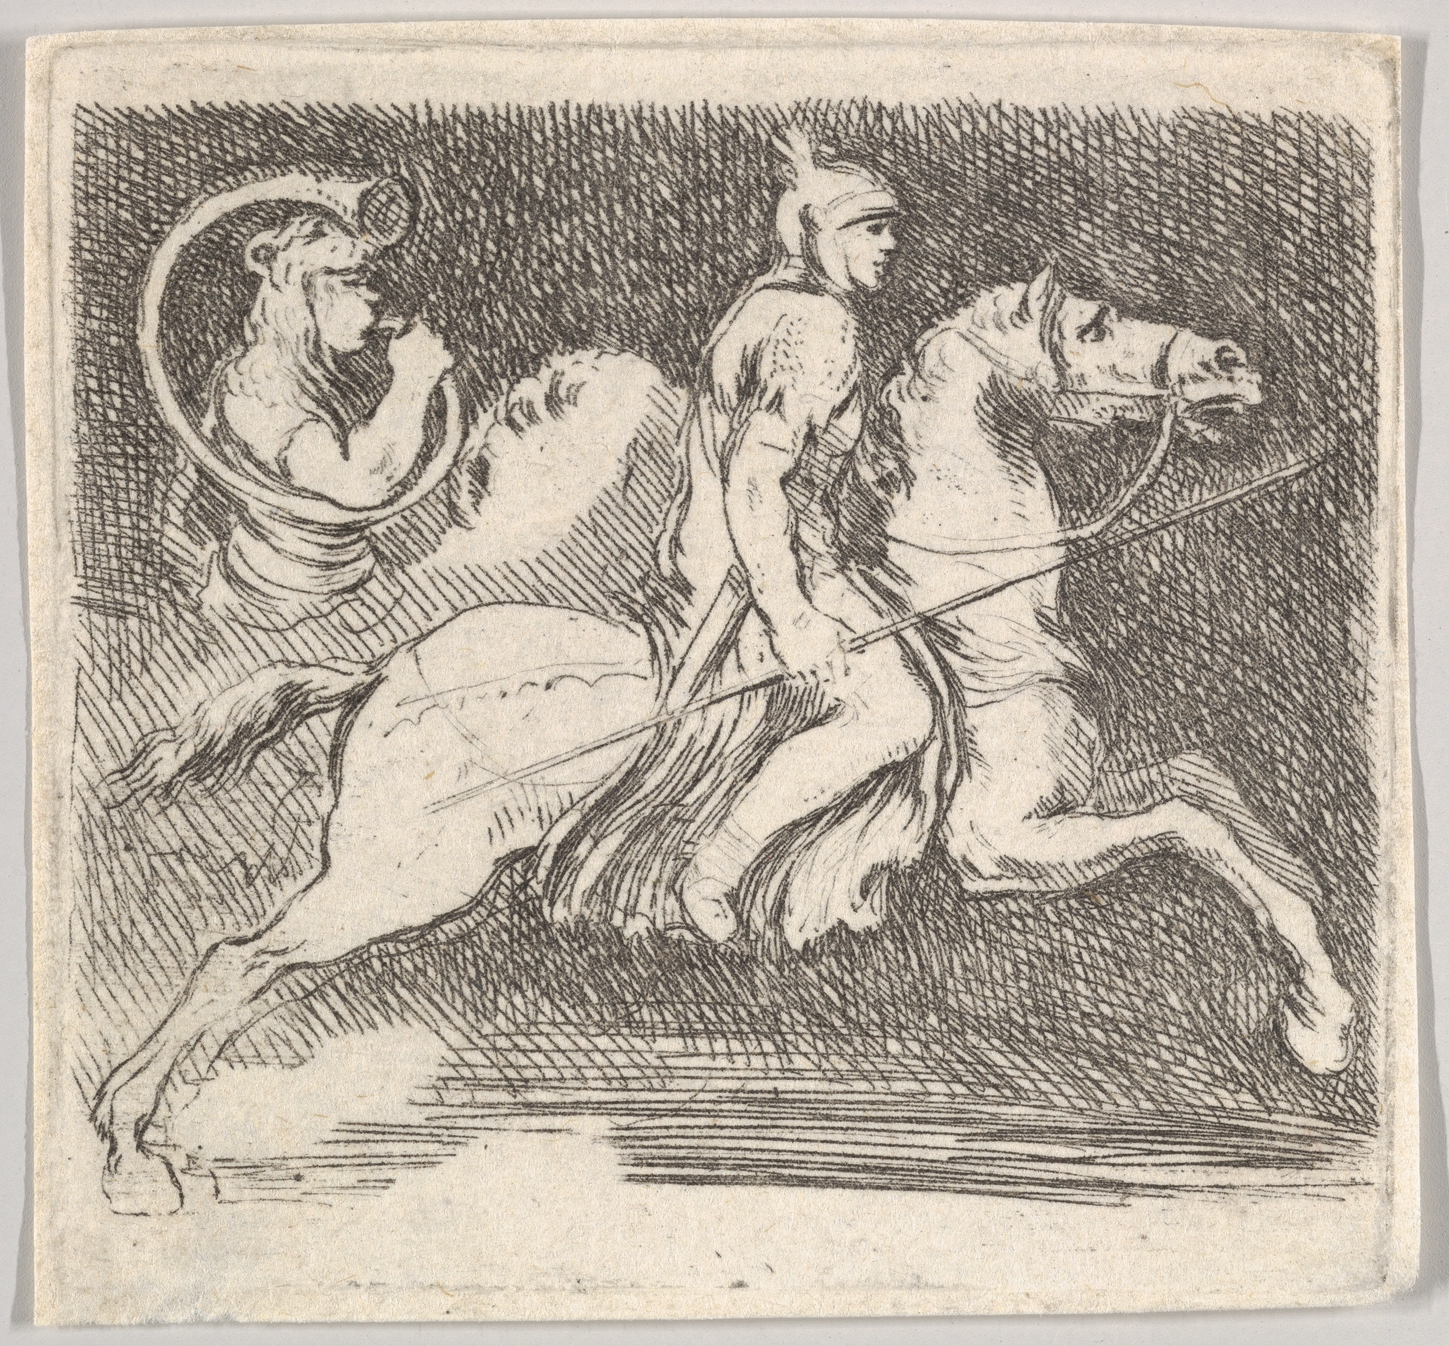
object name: print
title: A soldier in profile galloping to the right holding a lance in his right hand, followed by another horseman behind, plate 20 from "Various figures and doodles" (Diverses figures et griffonnemens)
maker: stefano della bella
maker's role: artist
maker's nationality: italian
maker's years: 1610-1664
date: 1646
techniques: etching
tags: musical instruments,soldiers,weapons,profiles,horses